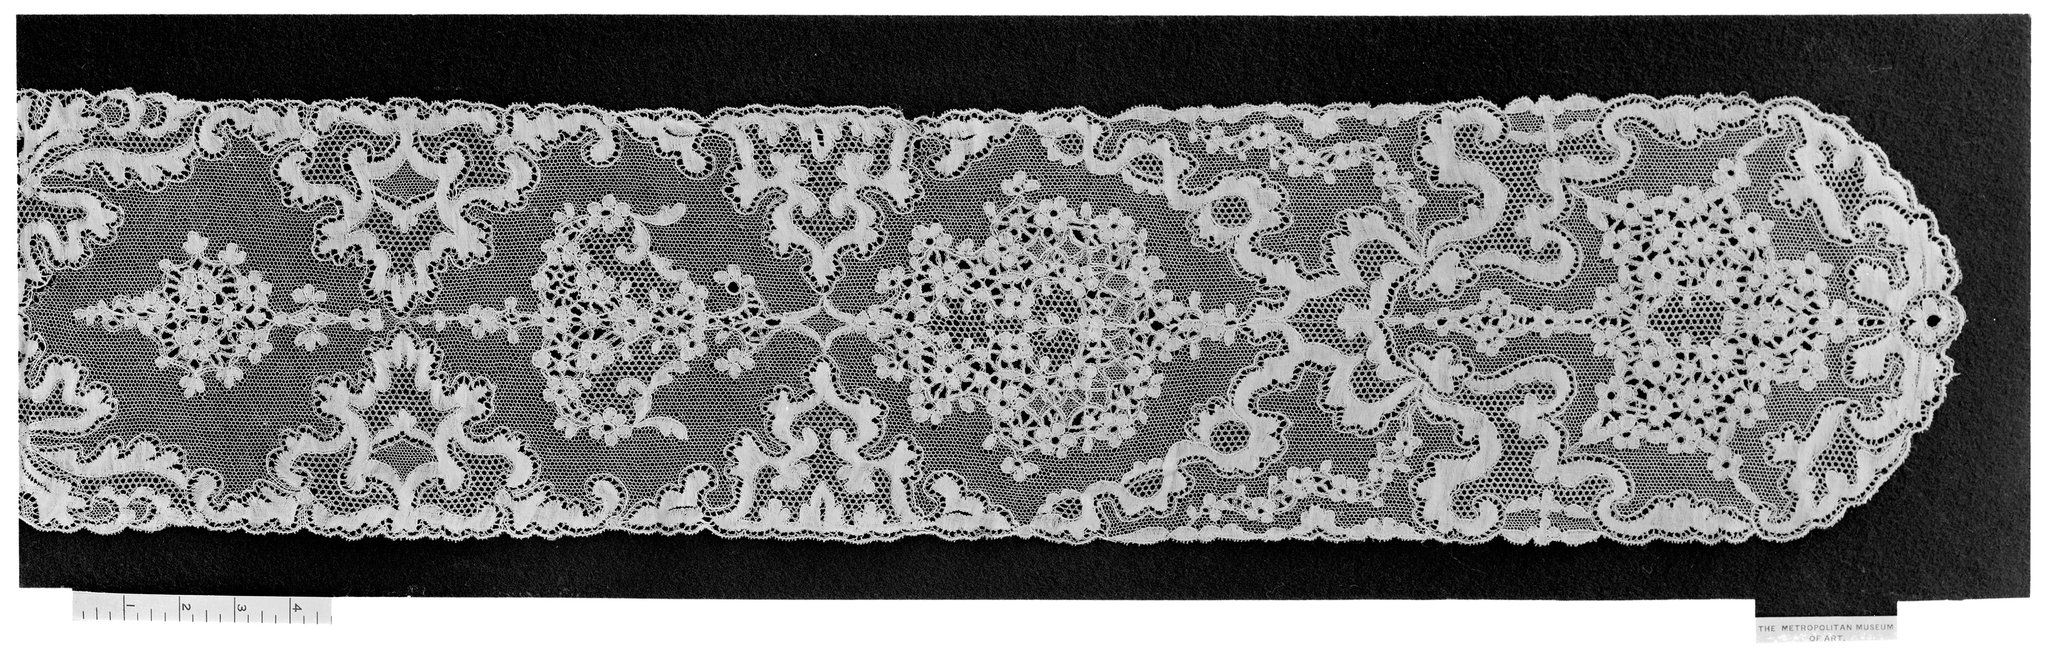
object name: barbe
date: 1801-1833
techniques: lace